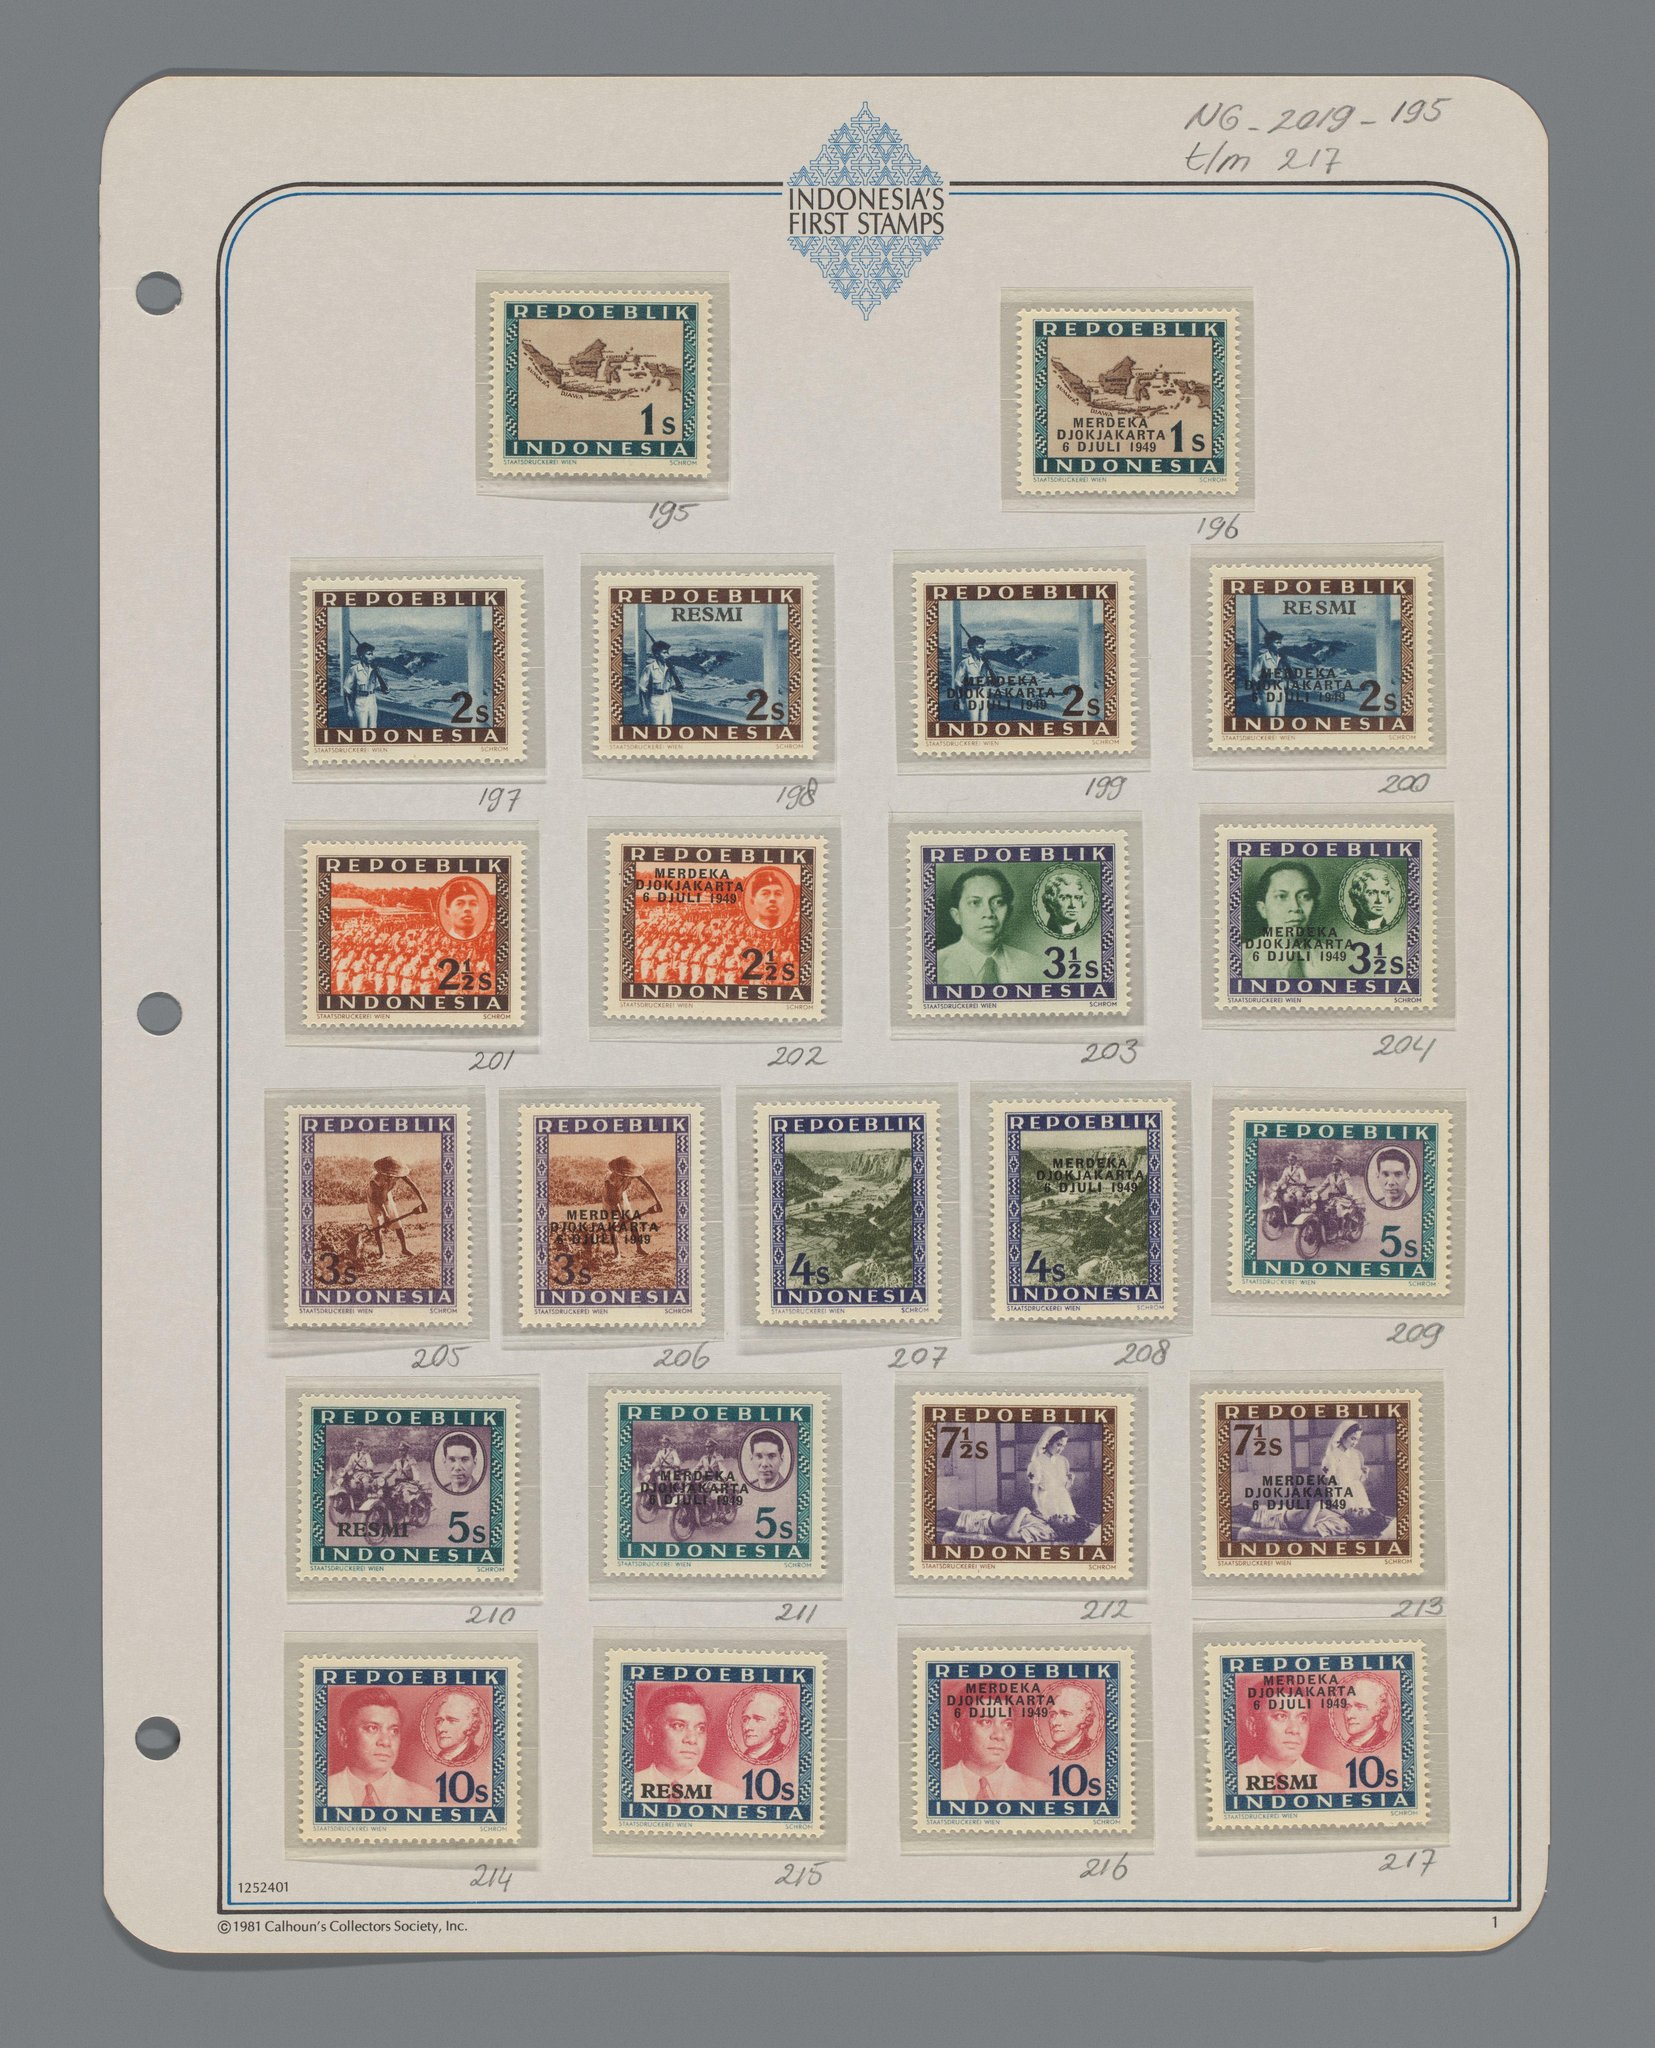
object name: postage stamp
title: Postzegel Republik Indonesia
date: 1949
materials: paper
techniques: photoaquatint, engraving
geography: vienna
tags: indonesia